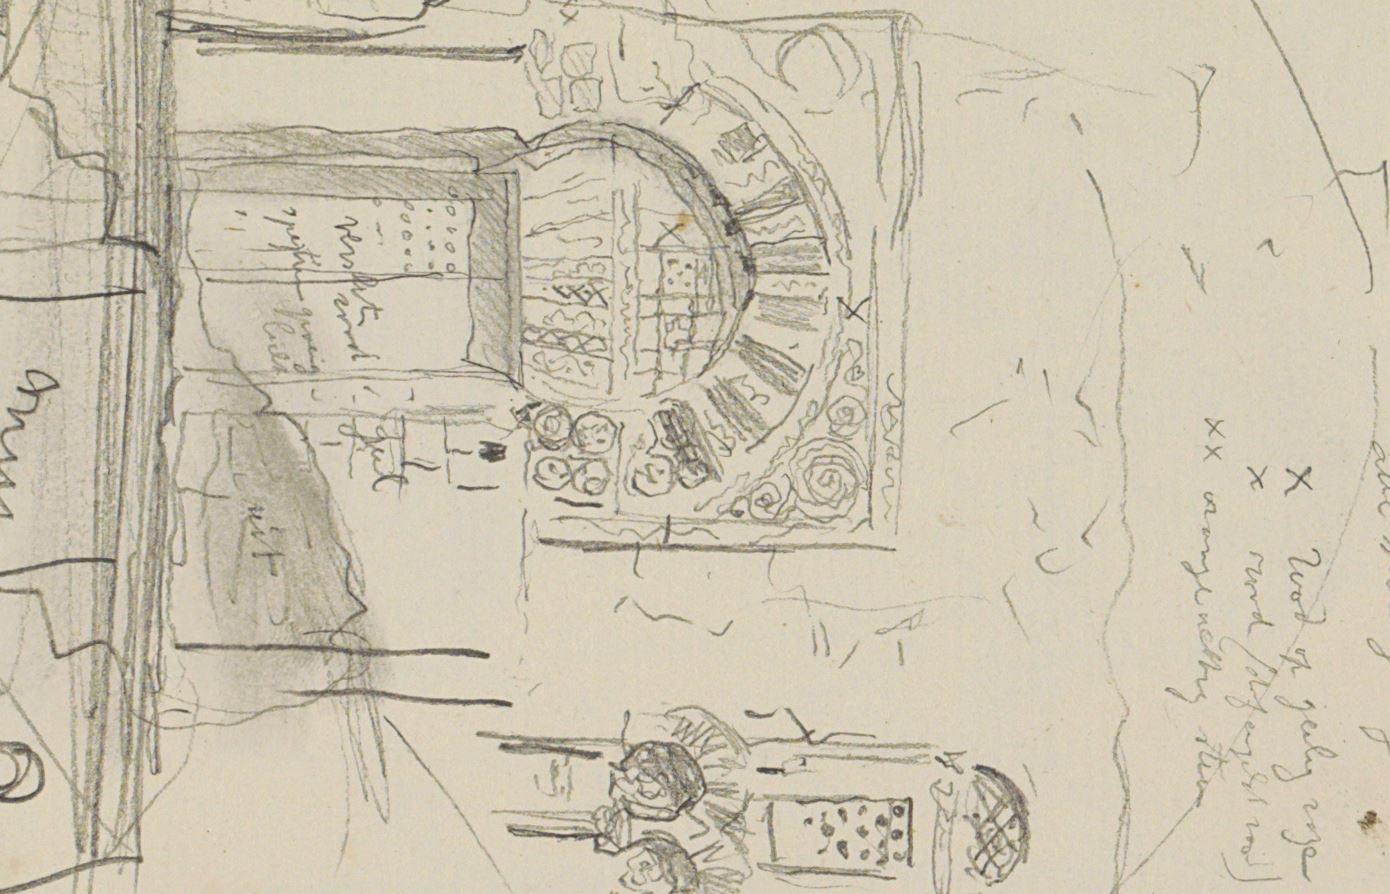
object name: sketchbook leaf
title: Figuur bij een portaal van de Mezquita kathedraal van Córdoba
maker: marius bauer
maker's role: draughtsman, print maker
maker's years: 1867-1932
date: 1902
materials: paper, pencil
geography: córdoba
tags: parts of church exterior and annexes: portal, standing figure, church (exterior)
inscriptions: annotation: ‘Cordoba’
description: Pagina 24 uit een schetsboek met 30 bladen.